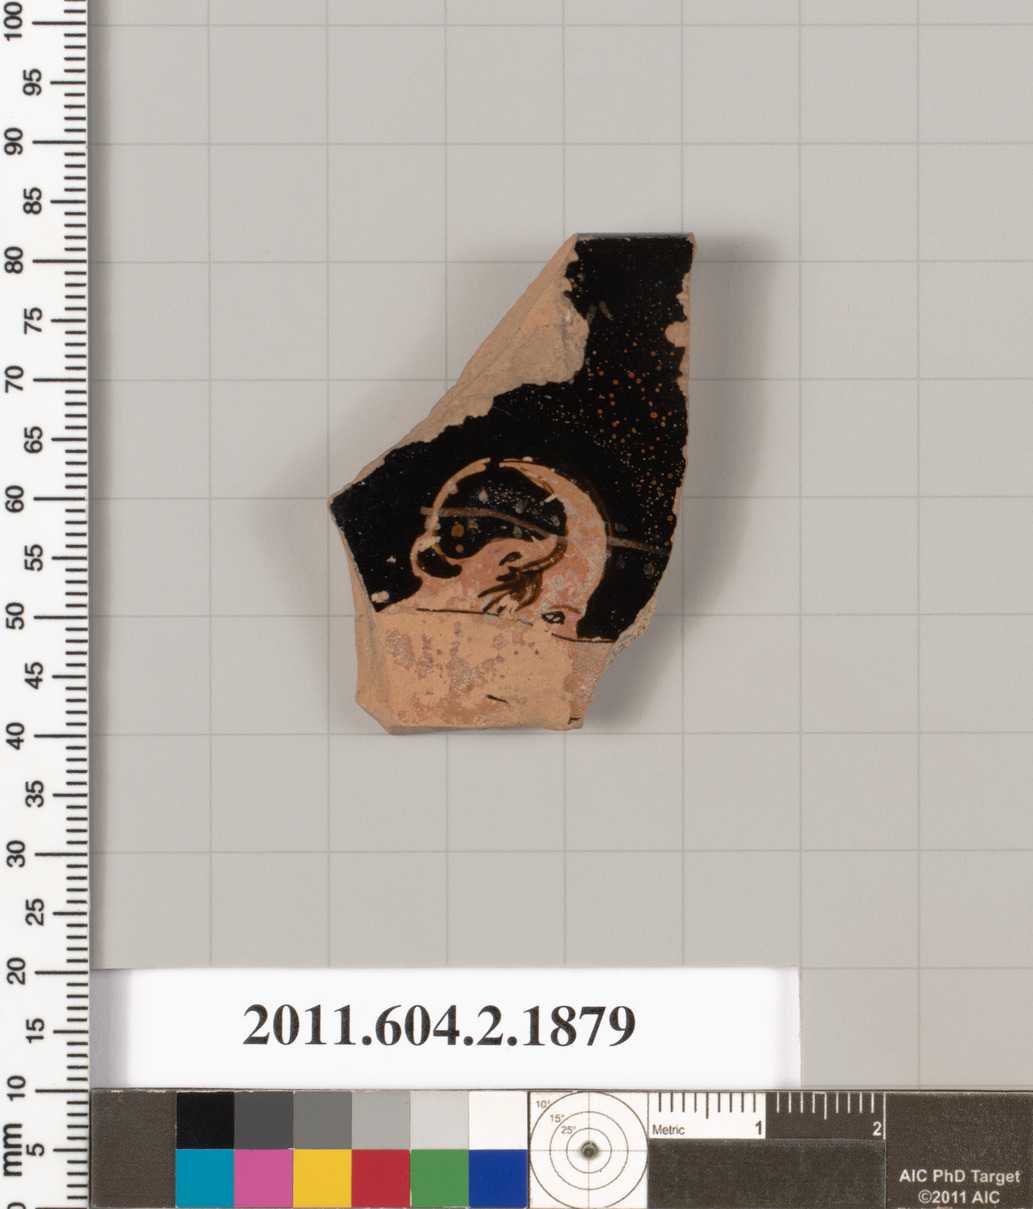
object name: skyphos fragment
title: Terracotta rim fragment of a skyphos (deep drinking cup)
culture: greek, attic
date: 425-401 BCE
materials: terracotta